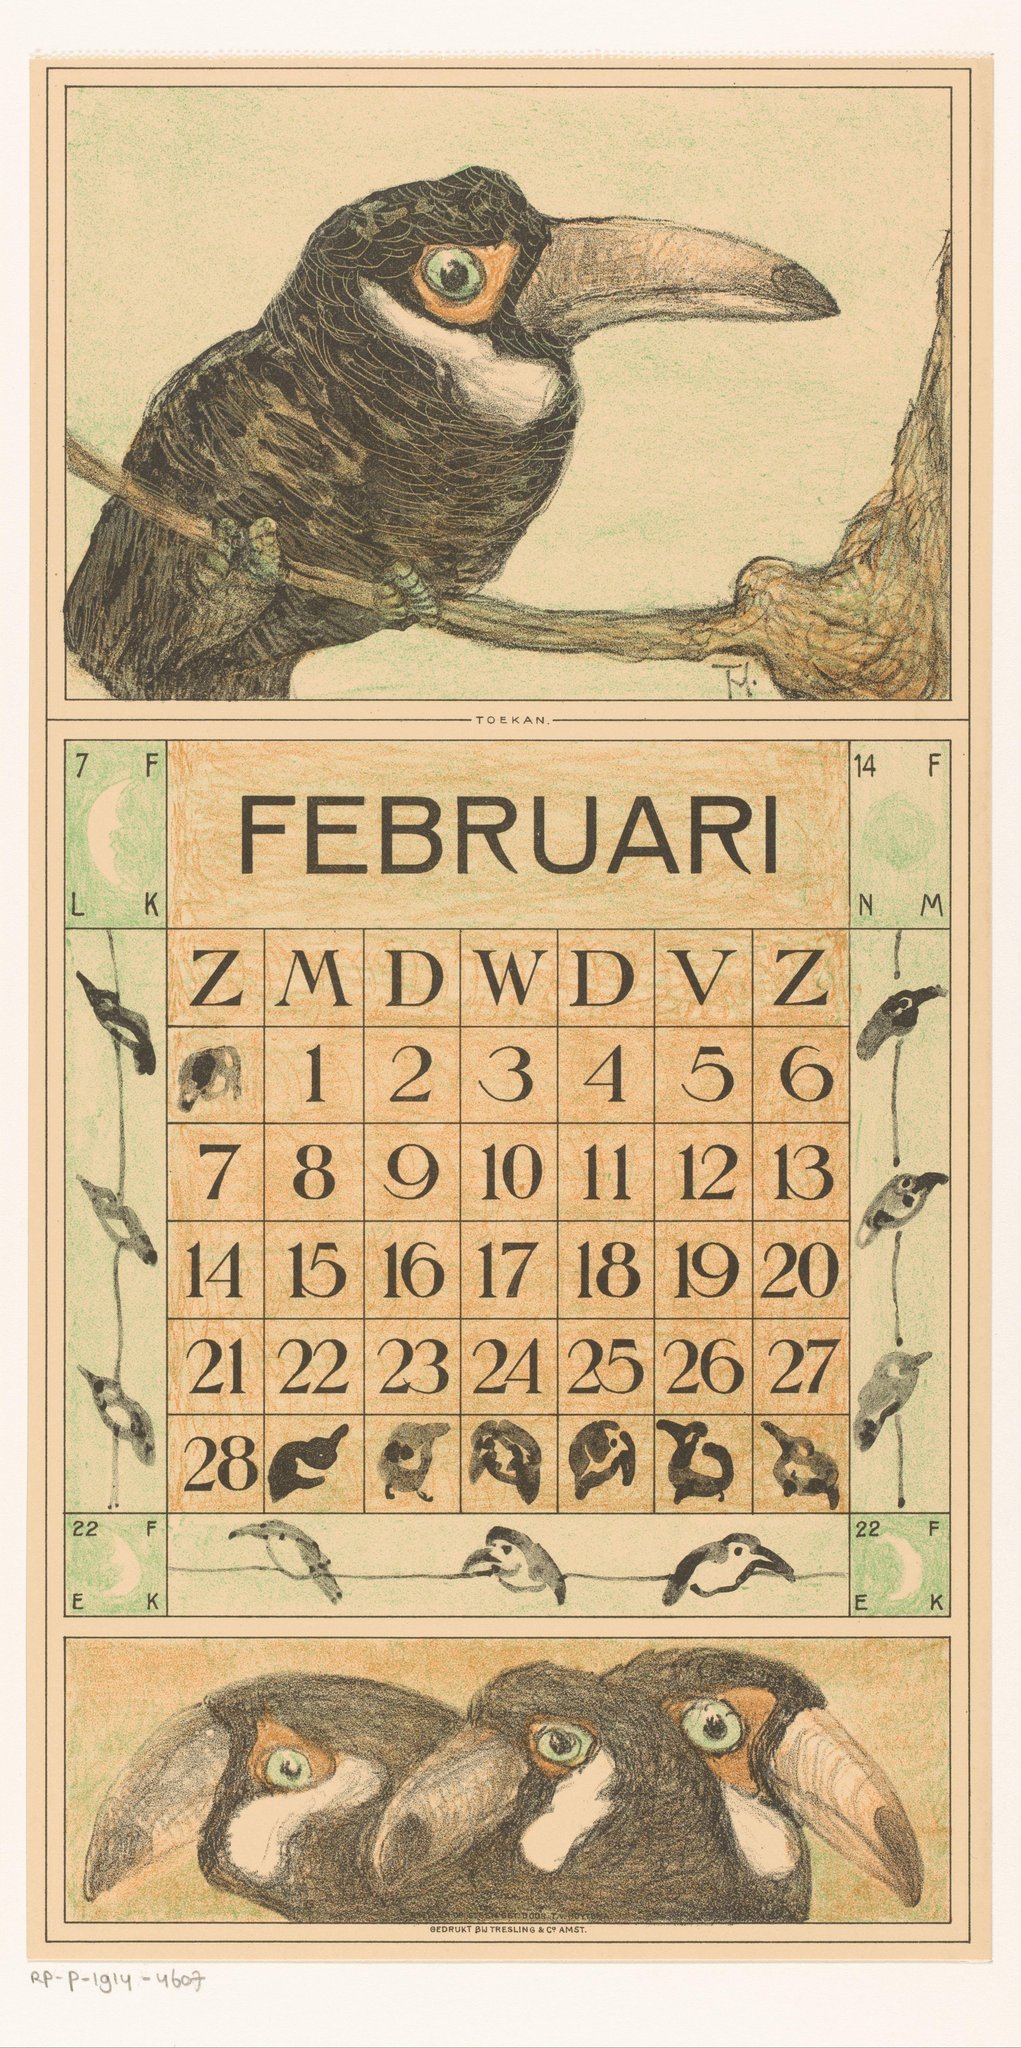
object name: calendar leaf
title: Toekan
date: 1914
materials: paper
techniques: lithograph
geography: amsterdam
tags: birds, lunar year, february ~ other concepts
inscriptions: collector's mark: Lugt 2233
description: In de ornamentrand en het calendarium vogels. Onderin drie toekans. In de hoeken de standen van de maan op vier dagen. Bovenaan het blad een scheurlijn.